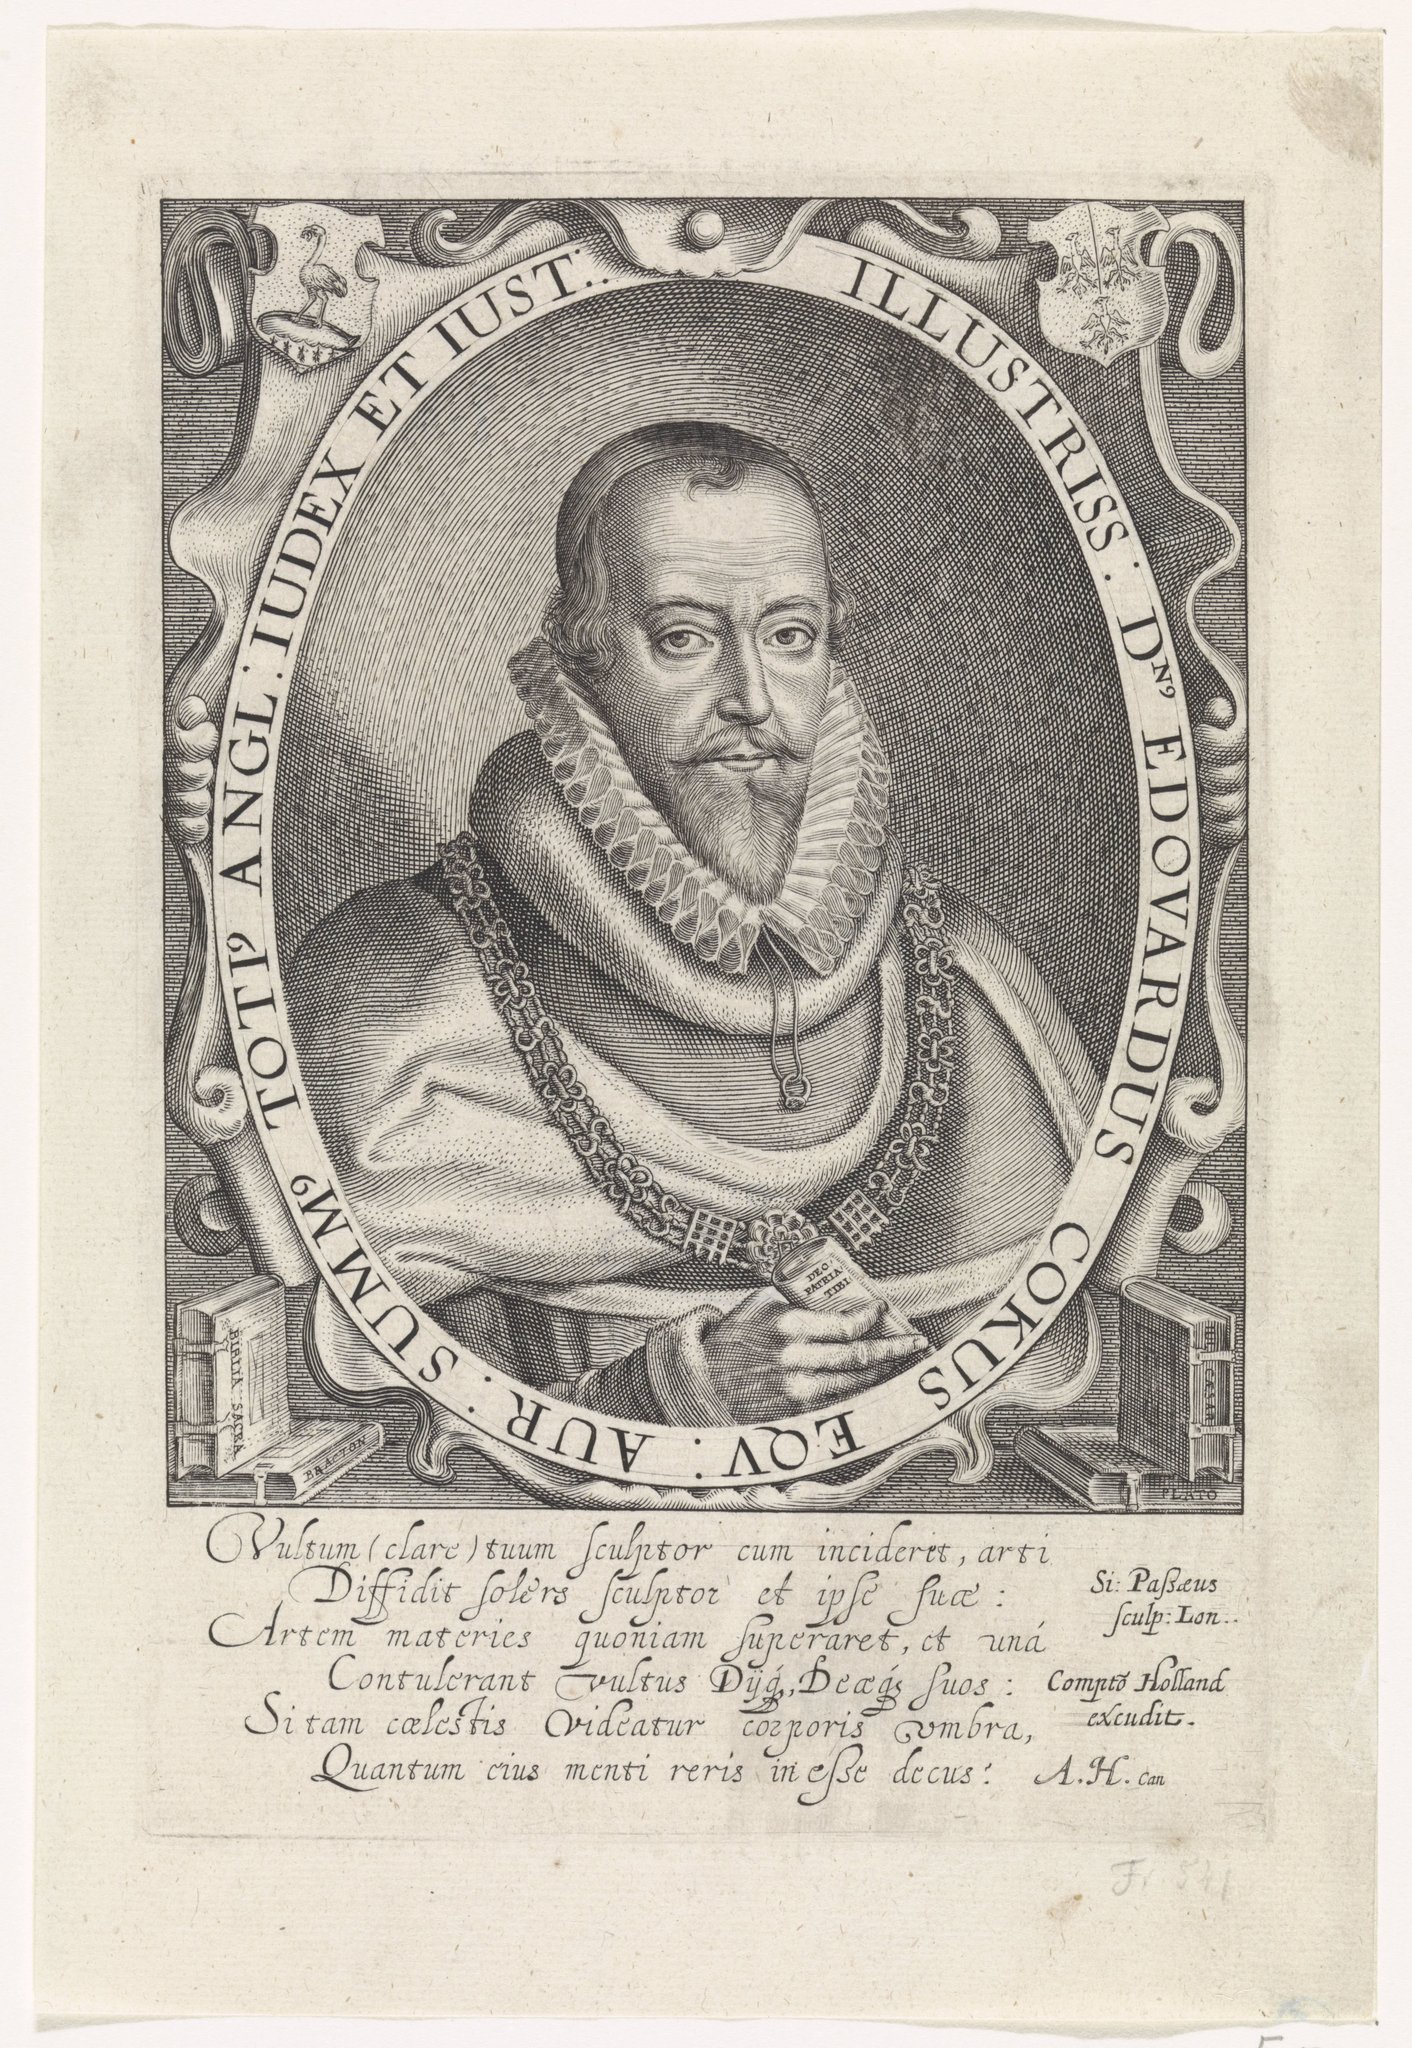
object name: print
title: Portret van Edward Coke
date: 1605-1647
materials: paper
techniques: engraving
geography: london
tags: politician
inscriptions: collector's mark: Lugt 2228, collector's mark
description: Portret van de jurist Edward Coke. In het randschrift van de omlijsting de naam en functie van de geportretteerde in het Latijn. In de hoeken het wapenschild van de geportretteerde en diverse boeken. In de marge een zesregelig lofdicht in het Latijn.